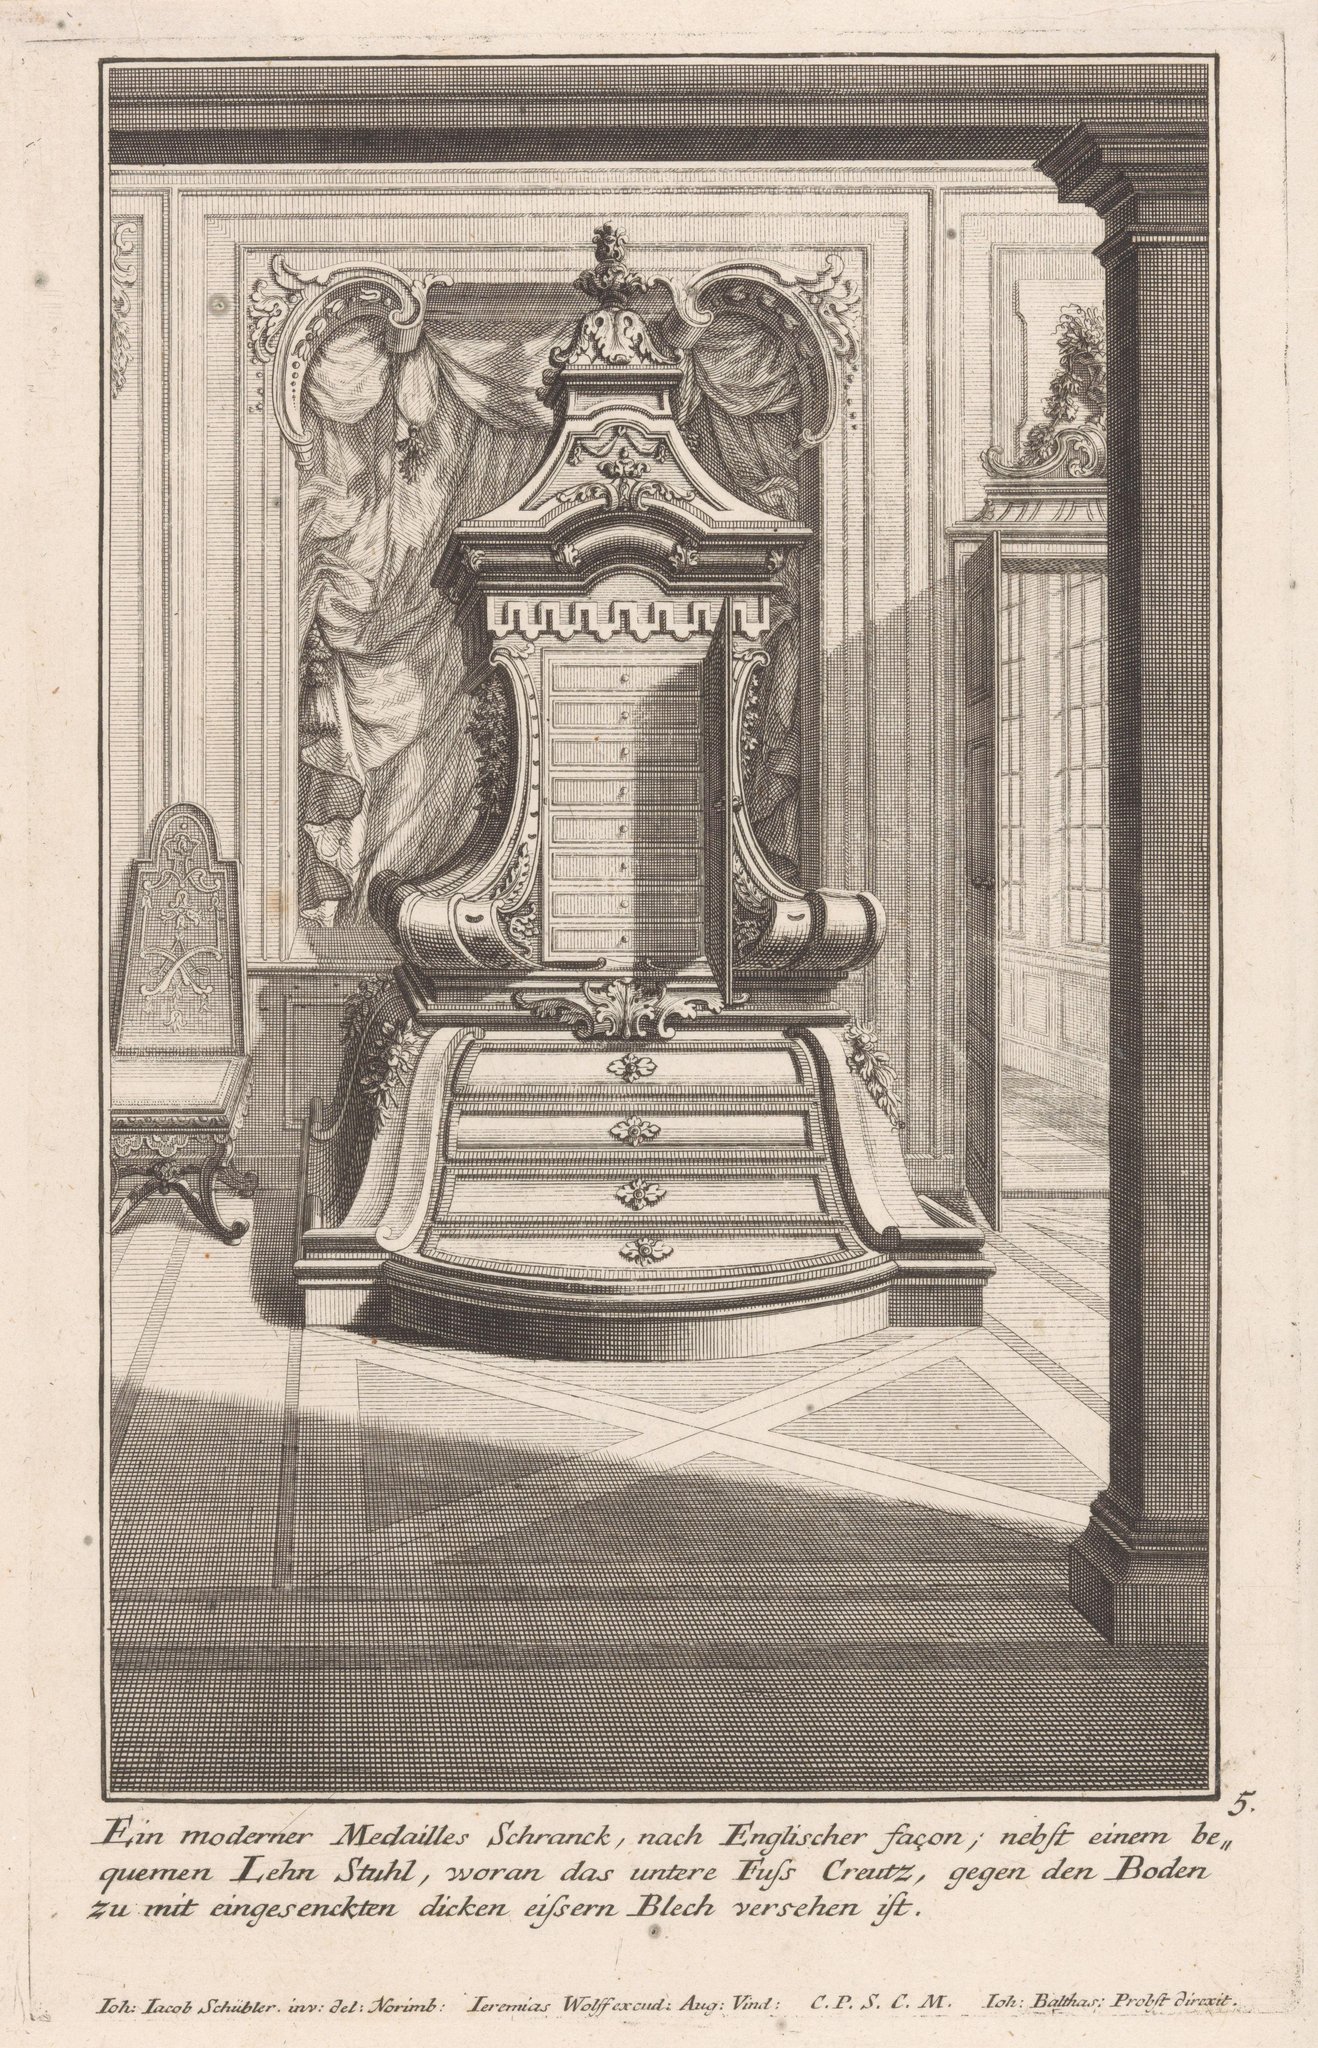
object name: ornament print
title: Johann Jacob Schüblers Vierdte Ausgab seines vorhabenden Wercks, Worinnen vorgestellet werden Neu-inventirte Schreib-Tische (...)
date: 1709-1724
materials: paper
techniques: engraving, etching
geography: nuremberg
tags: furniture for storage, chair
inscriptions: collector's mark: Lugt 2760, collector's mark: Lugt 2228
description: Prent uit: Schübler, Johann Jacob. Erste [-Zwanzigste] Ausgabe seines vorhabenden Wercks (...). Augsburg: Wolf, erven Jeremias, [na 1724]